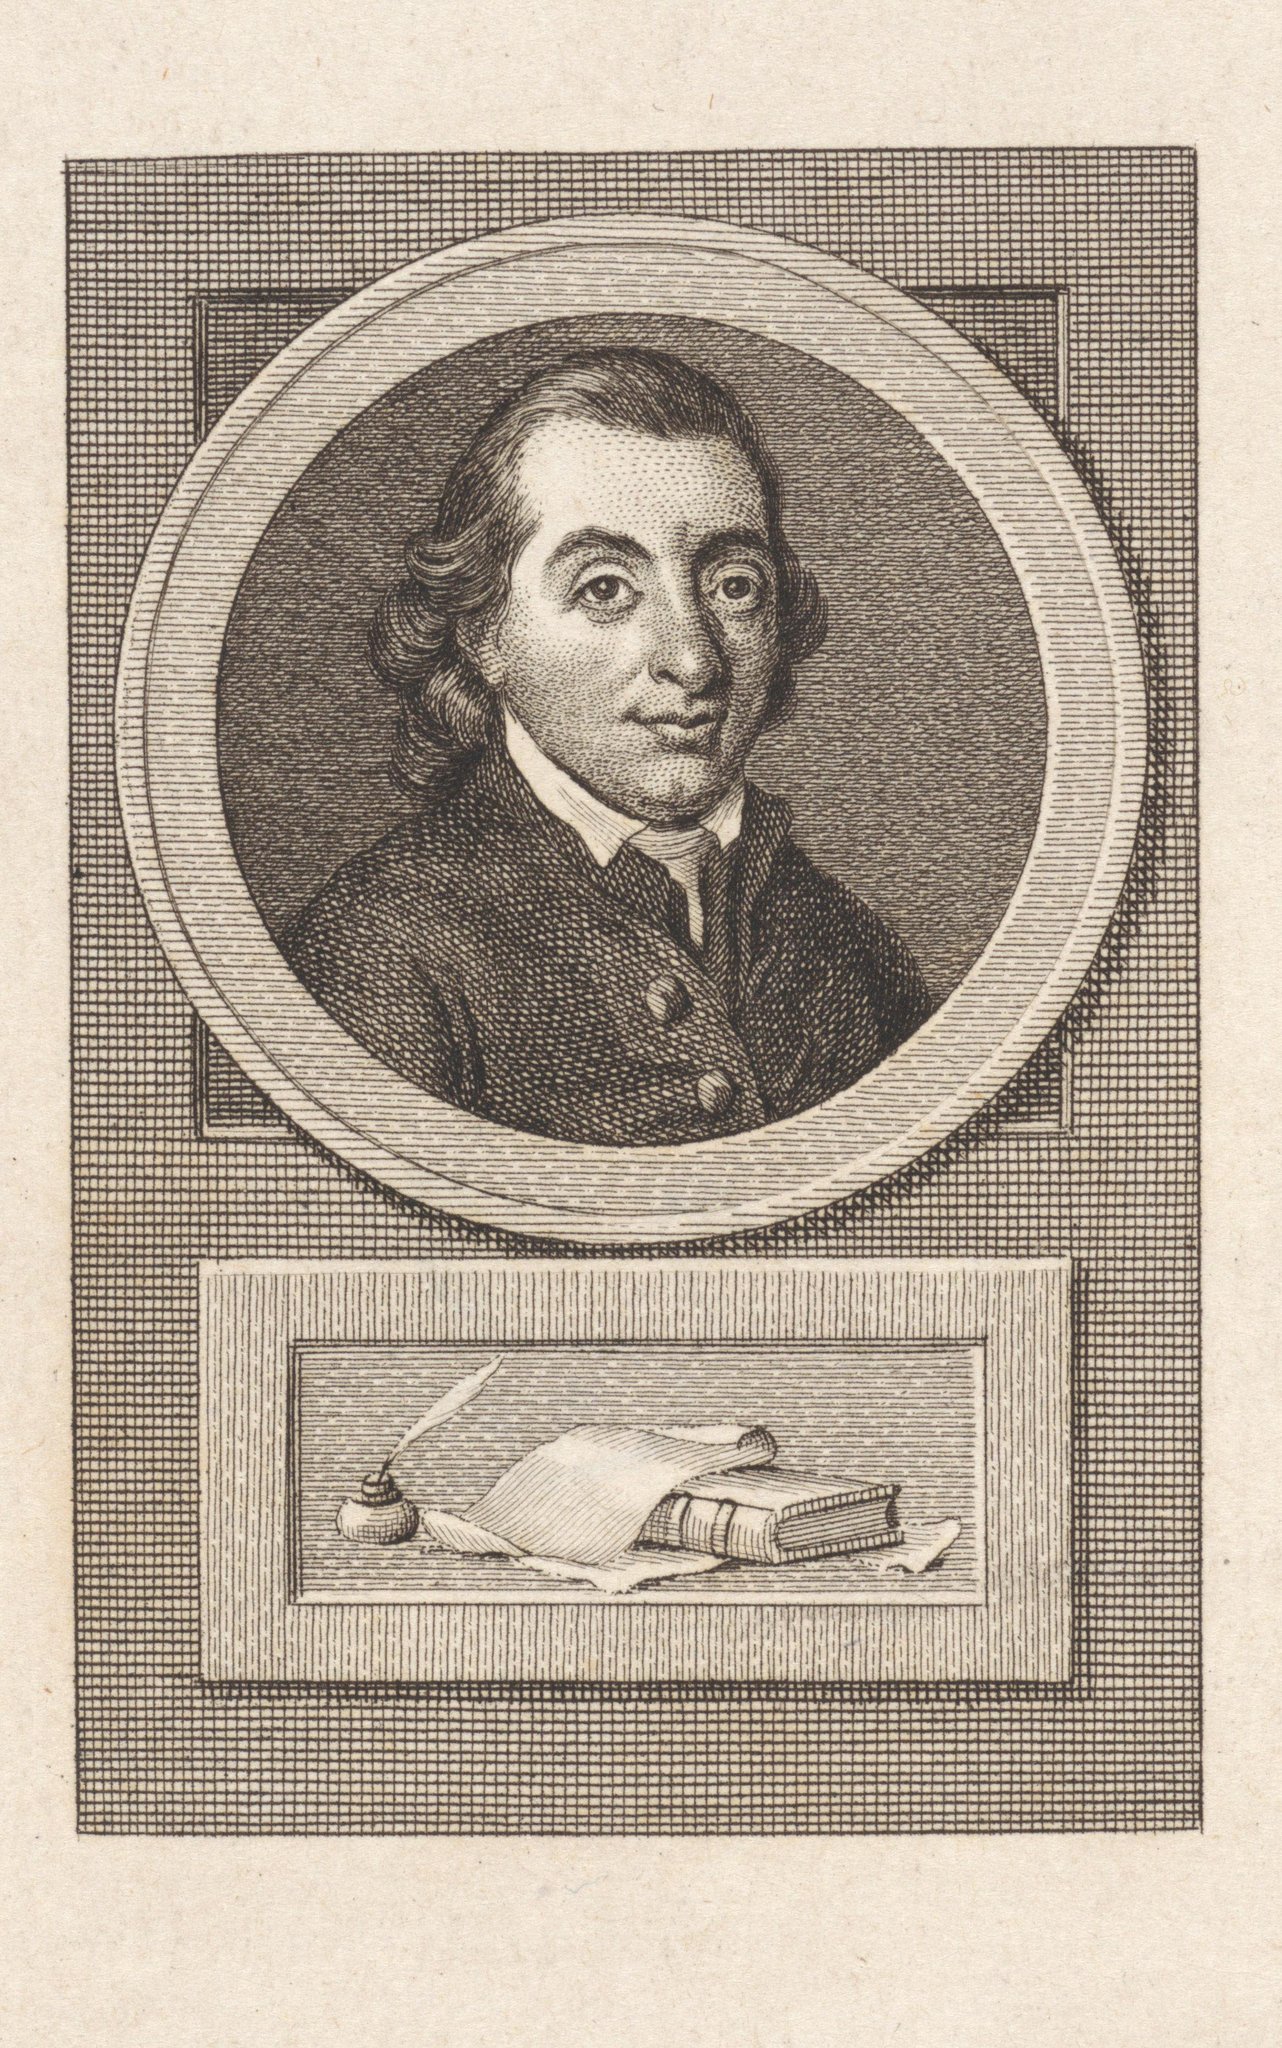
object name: print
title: Portret van Bernardus de Bosch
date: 1783-1795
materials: paper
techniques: engraving, etching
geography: amsterdam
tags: deventer, the hague, quill, ink-well, book, paper (writing material)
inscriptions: collector's mark: Lugt 2228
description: Latere staat prent gebruikt in: Fokke, Jan. Geschiedenissen der Vereenigde Nederlanden voor de vaderlandsche jeugd Ie-XXVste deel. Amsterdam: Johannes Allart, 1783-1795. Deel XXII.